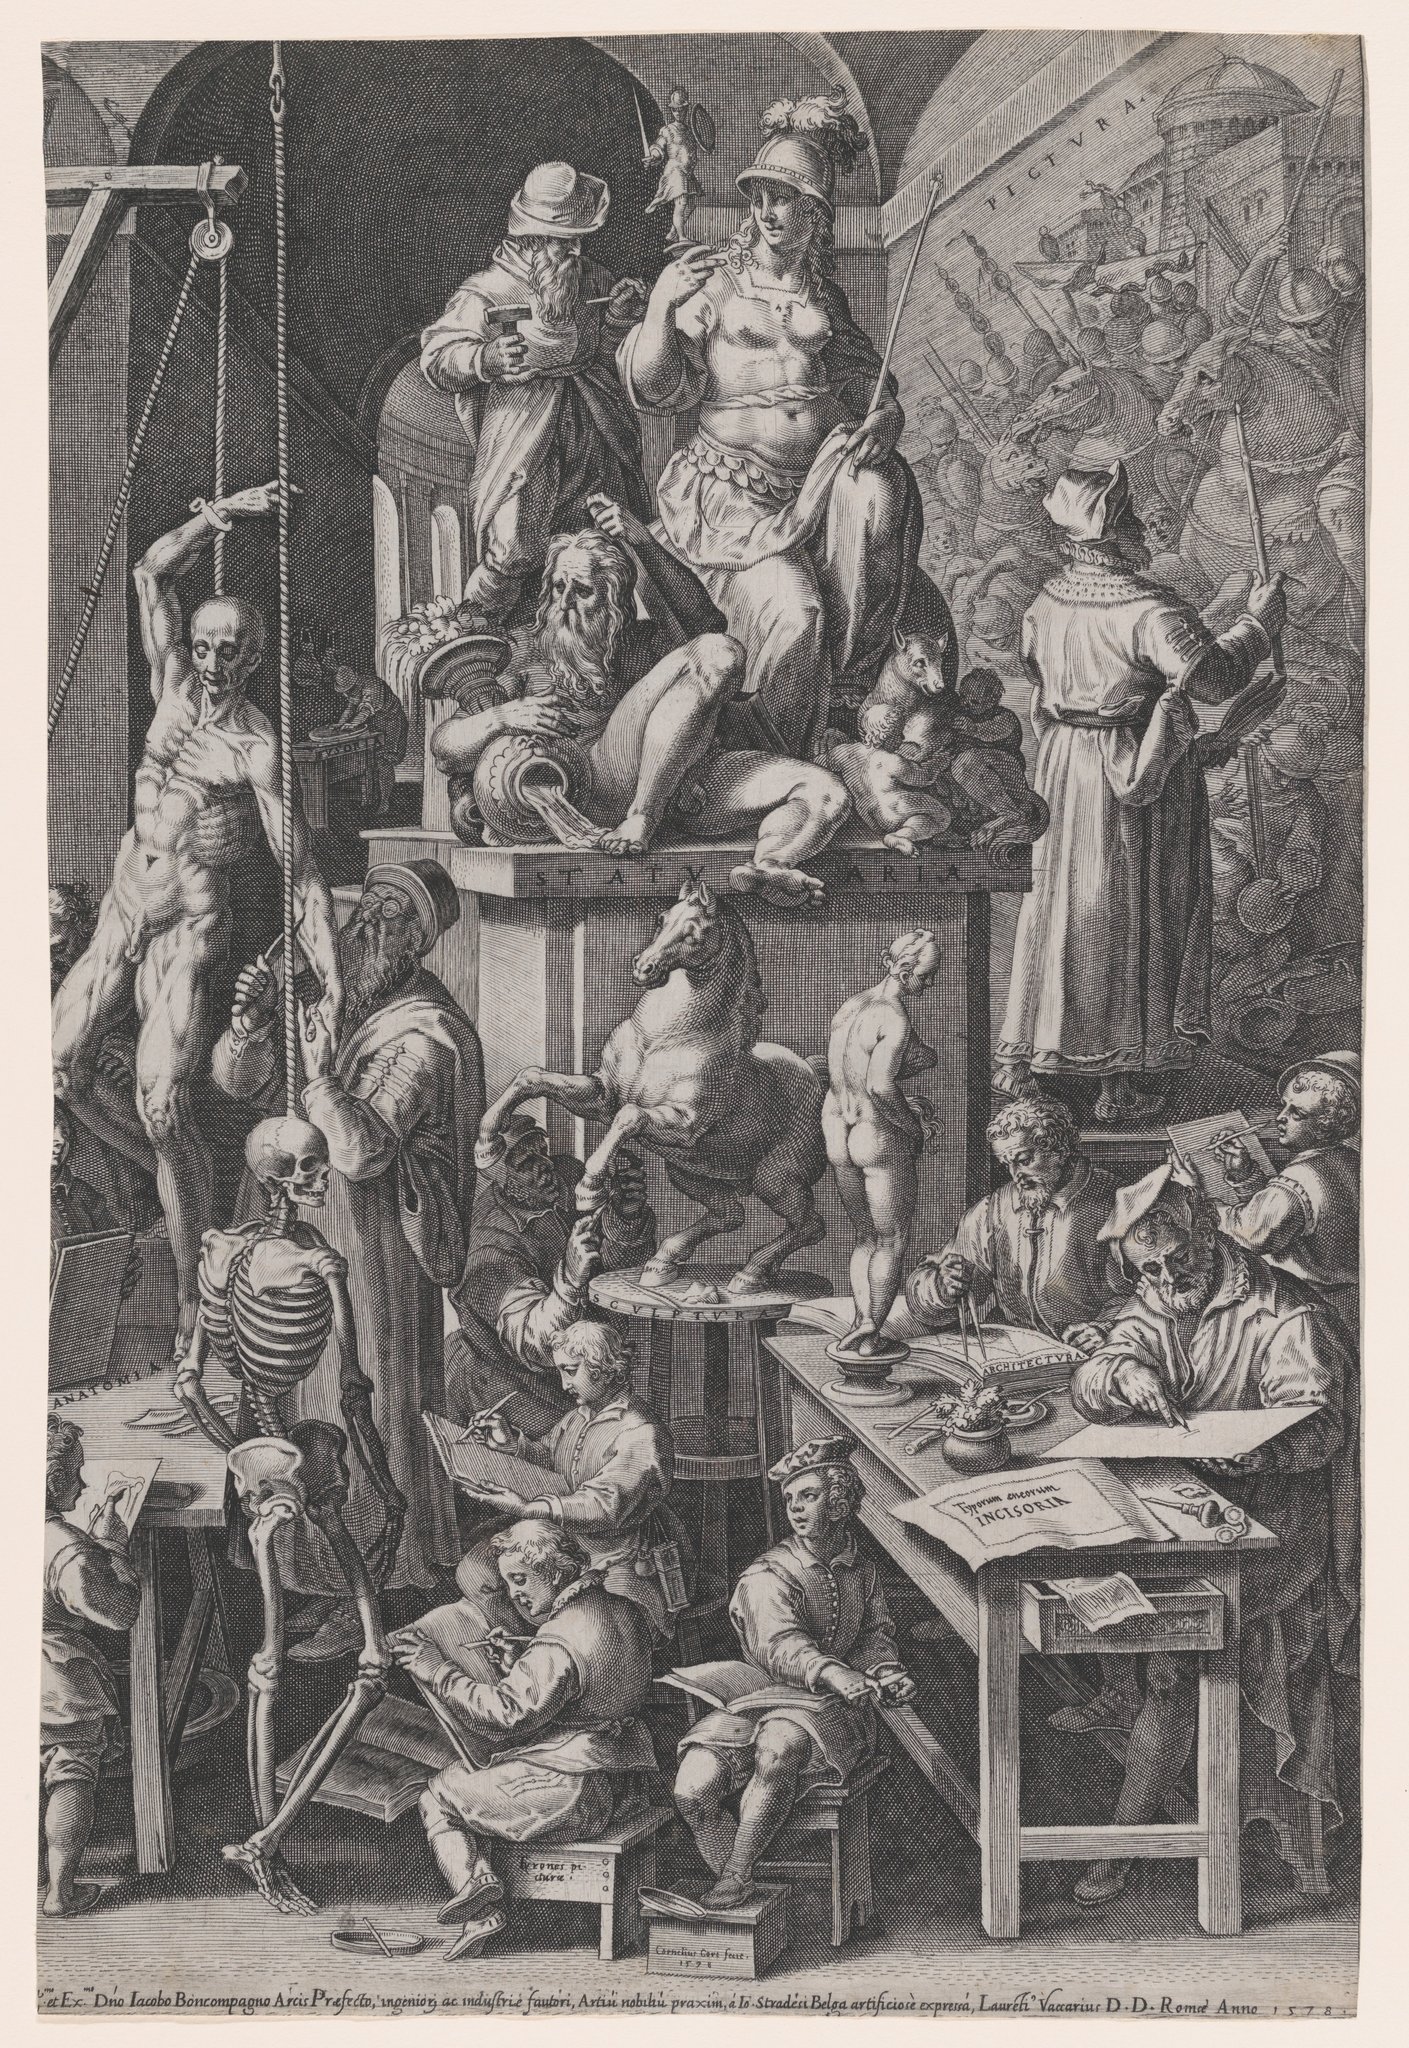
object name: print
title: The Practitioners of the Visual Arts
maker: cornelis cort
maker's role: artist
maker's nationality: netherlandish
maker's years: 1533-1578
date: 1578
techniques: engraving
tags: drawing,painting,skeletons,male nudes,female nudes,horses